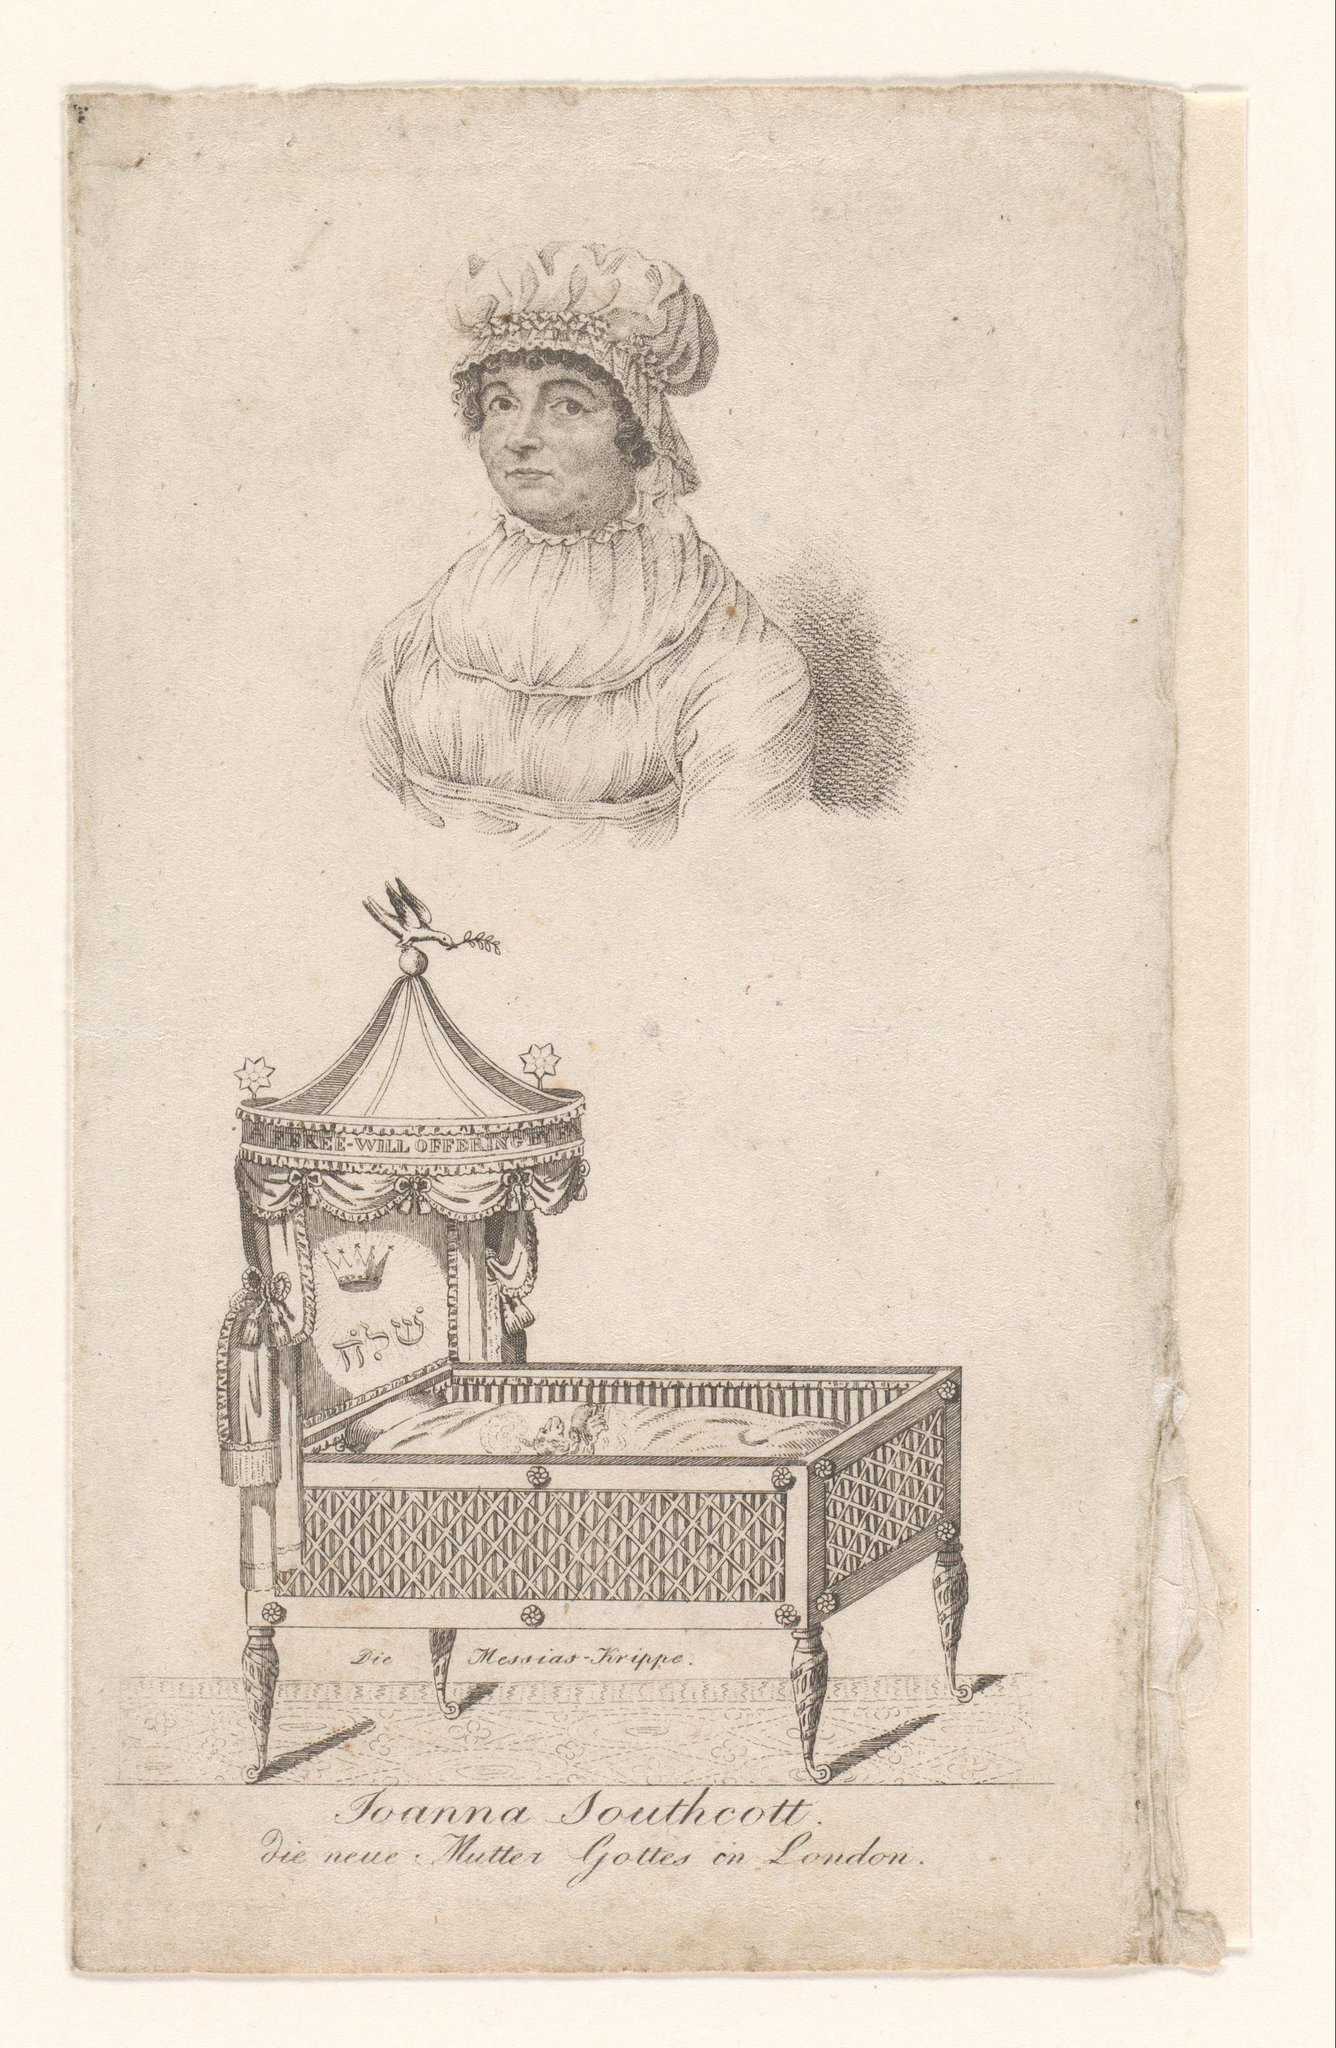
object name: print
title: Joanna Southcott, die neue Mutter Gottes in London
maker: Anonymous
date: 1821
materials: paper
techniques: etching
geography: germany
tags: historical persons - bb - woman, cradle, crib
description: Southcott beweerde dat zij zwanger was van de nieuwe Messias, die 19 oktober 1814 geboren zou worden. Prent waarschijnlijk uit: Niemeyer, August Hermann. Beobachtungen auf Reisen in und ausser Deutschland (...). Halle: Buchhandlung des Hallischen Waisenhauses, 1821, dl. 2.